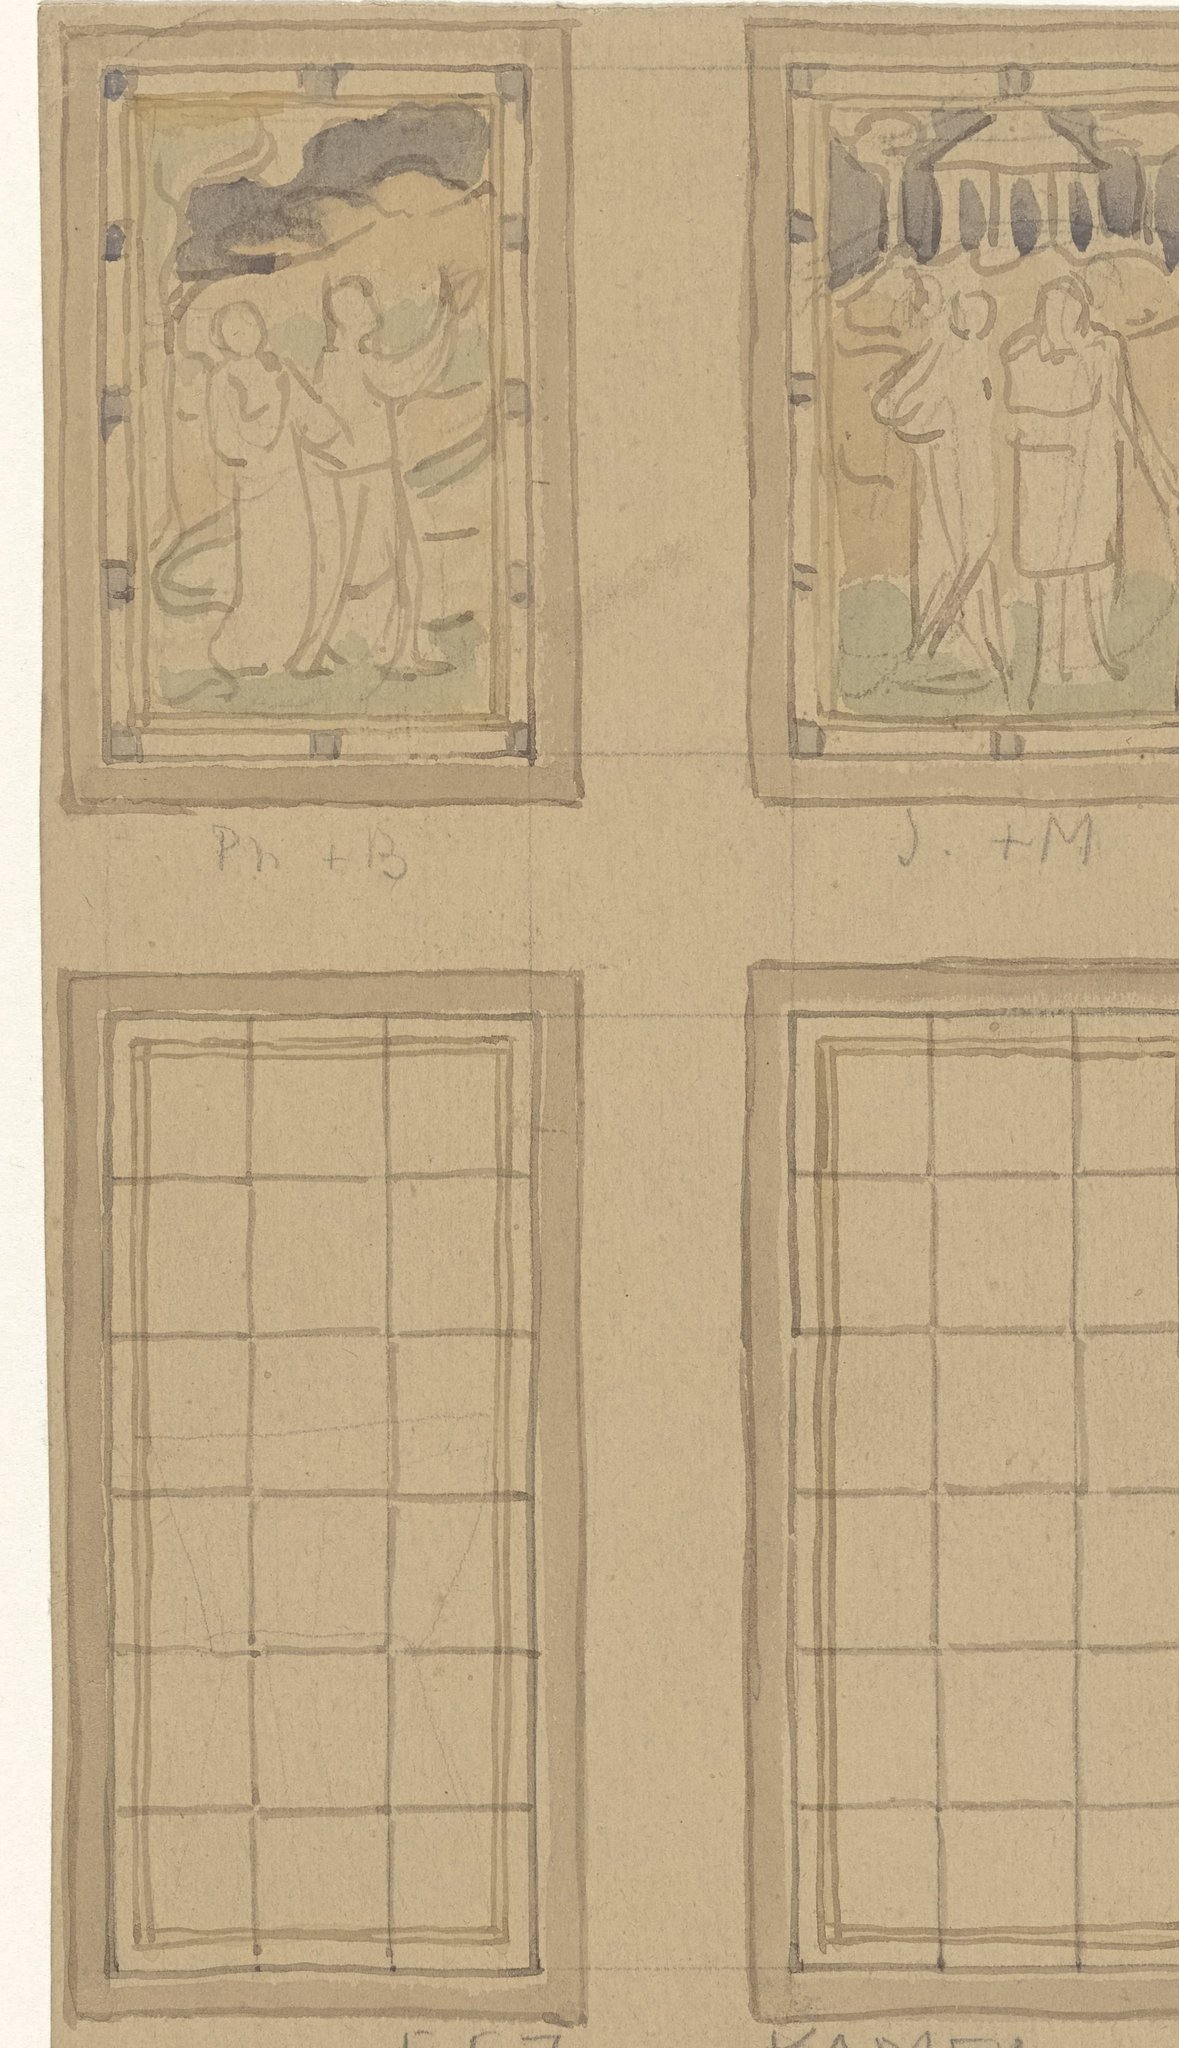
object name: drawing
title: Ontwerp voor glasschildering met Philemon, Baucis, Jupiter en Mercurius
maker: antoon derkinderen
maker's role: draughtsman, painter, print maker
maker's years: 1859-1925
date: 1869-1925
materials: ink, paper, pencil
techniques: brush, pen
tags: non-aggressive, friendly or neutral activities and relationships of philemon and baucis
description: Ontwerp voor glasschildering in het huis van A.J. Derkinderen, te Laren, 'Eet-Kamer': links Philemon en Baucis, rechts Jupiter en Mercurius.